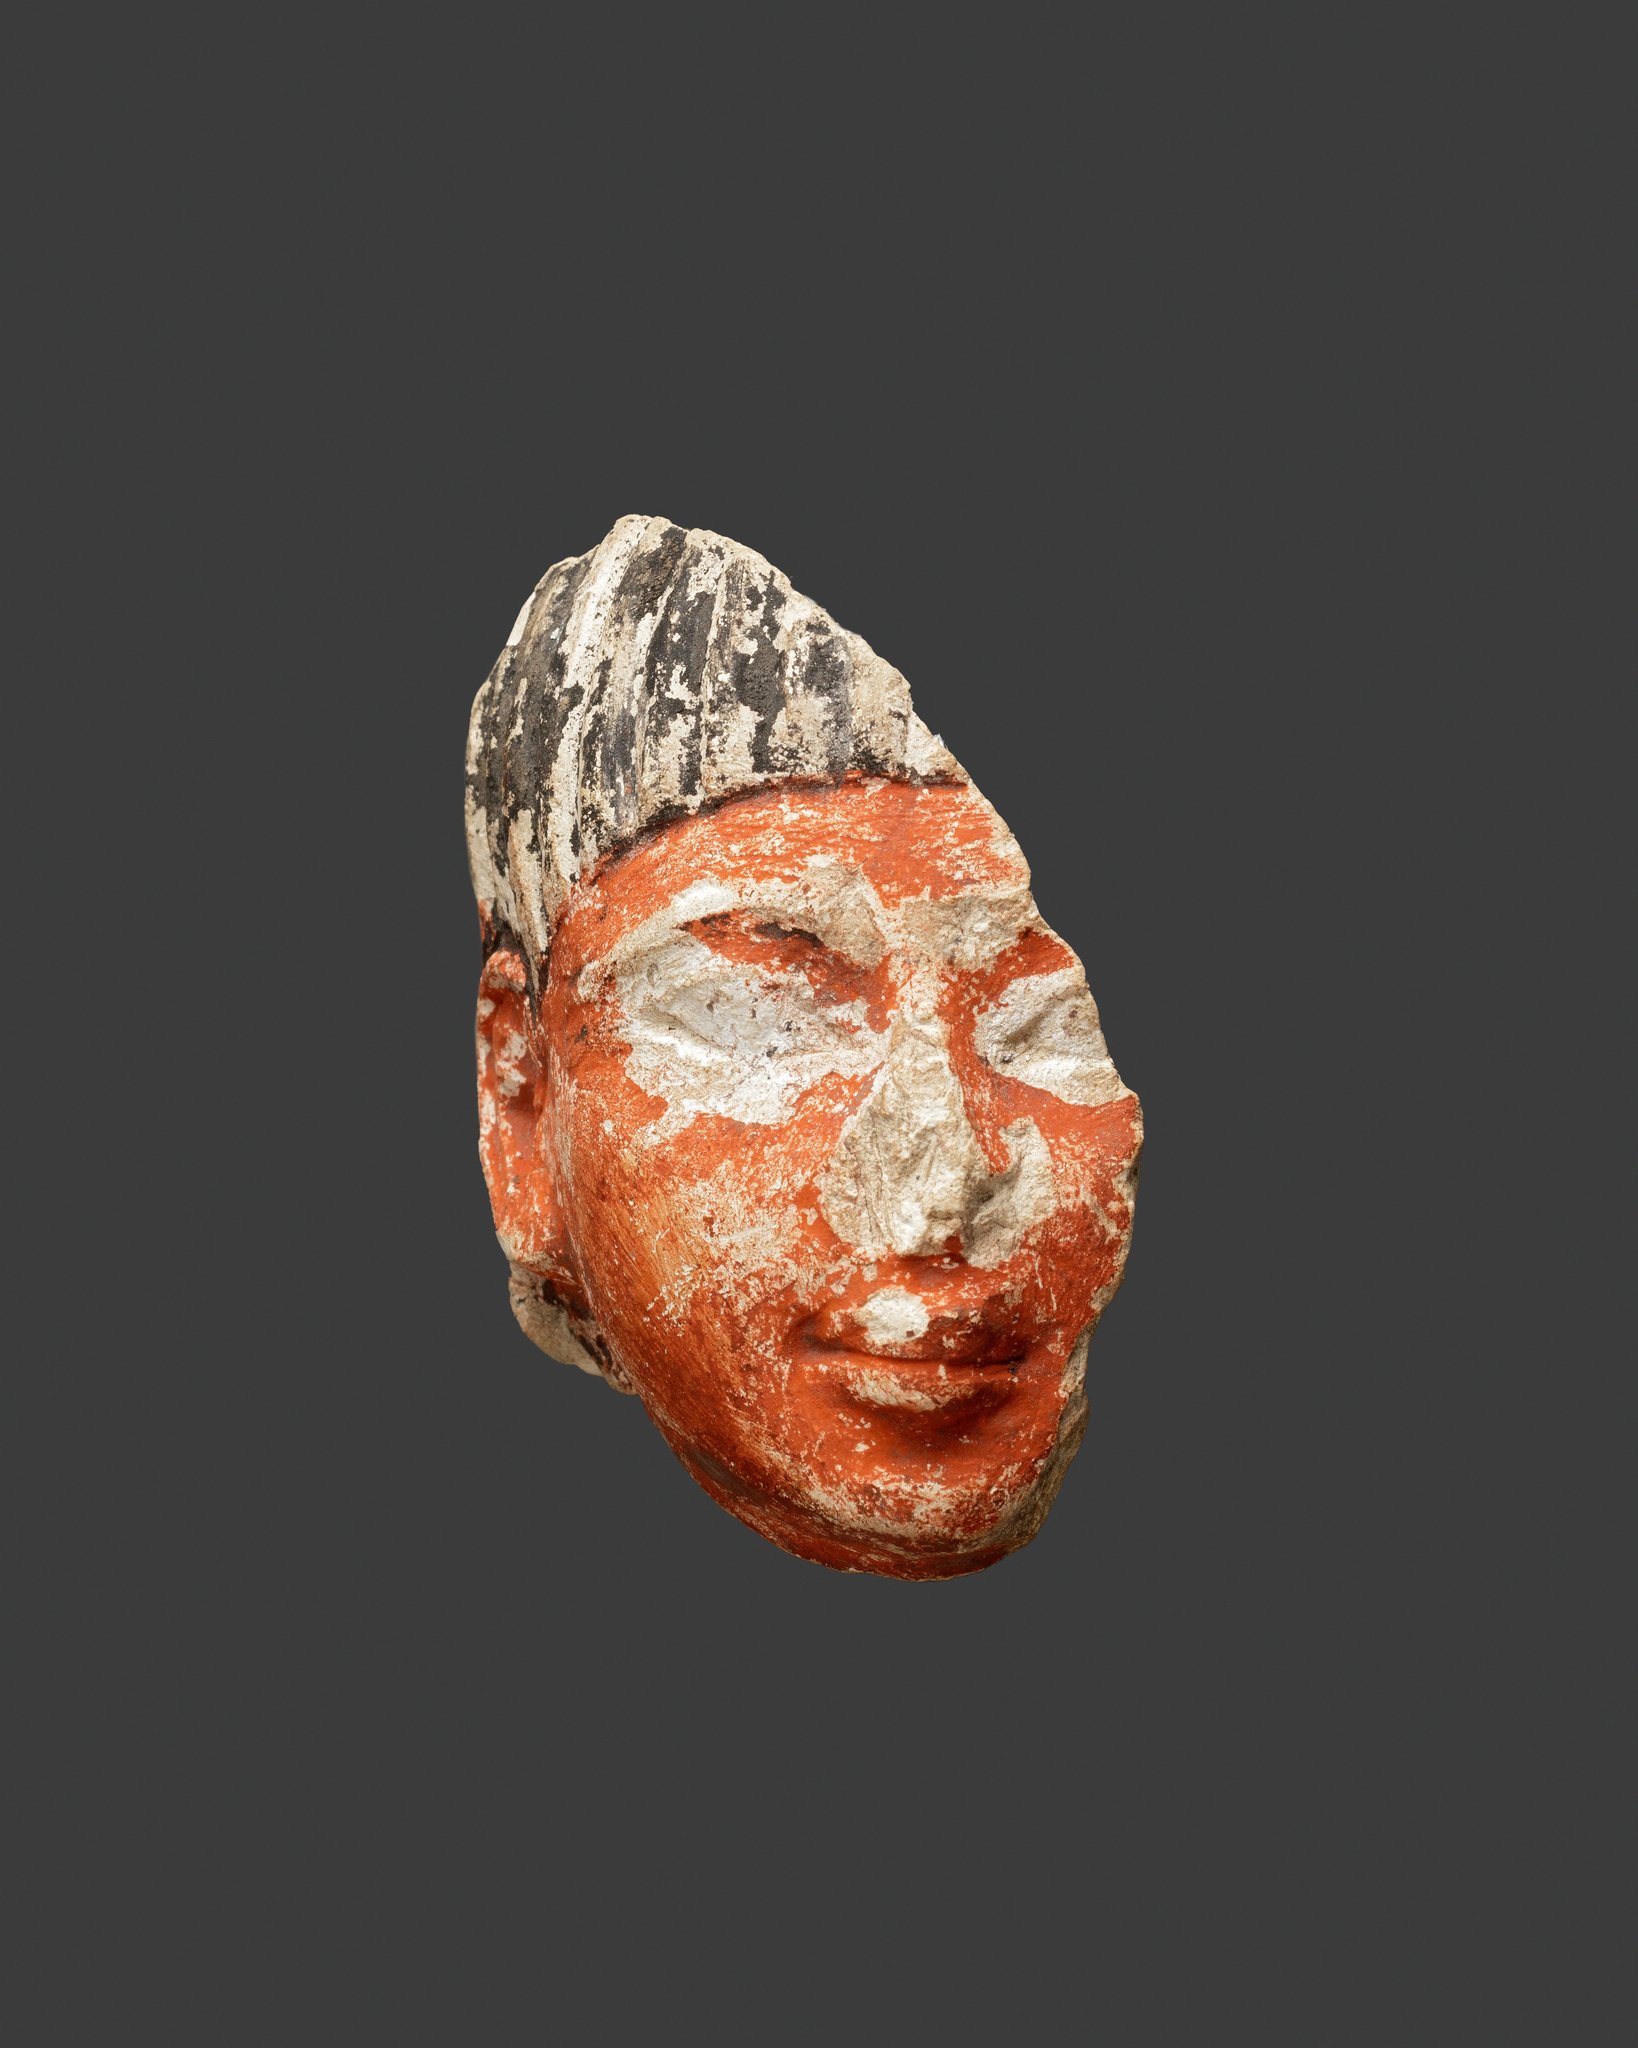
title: Fragmentary Head of a Man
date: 1550-1070 BCE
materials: limestone, paint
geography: egypt